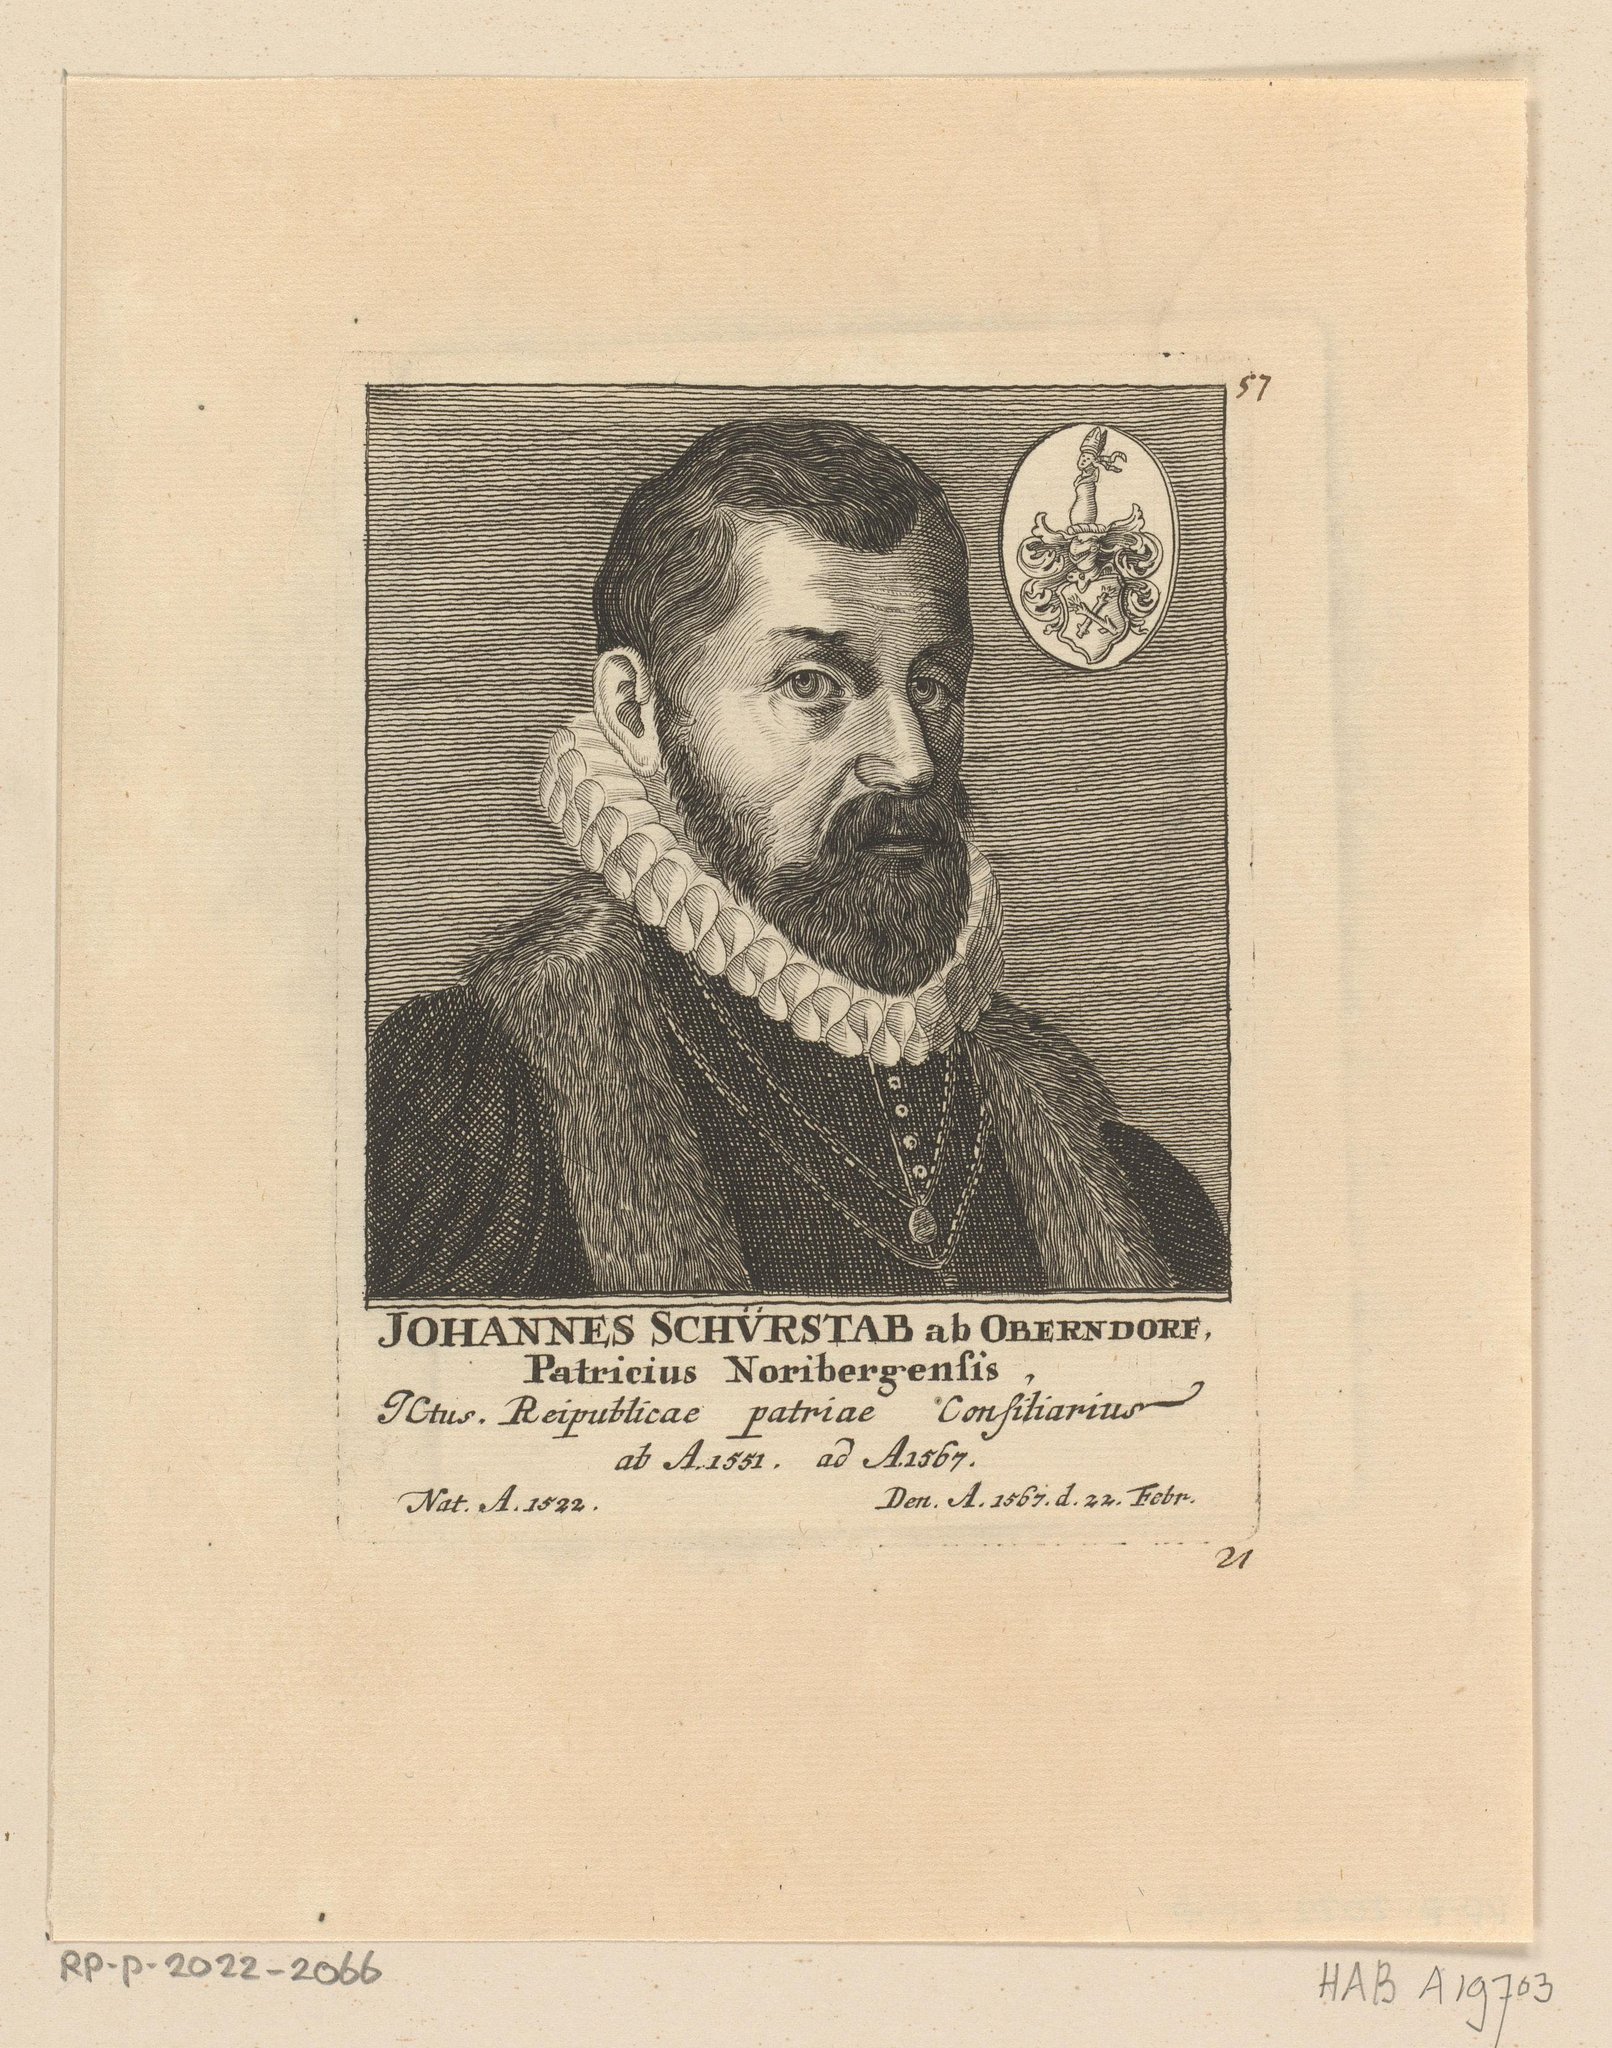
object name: print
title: Icones consiliariorum de illustri republica Noribergensi (…)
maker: Anonymous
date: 1723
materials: paper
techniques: engraving, etching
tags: historical persons, lawyer, attorney at law, armorial bearing, heraldry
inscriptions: number: ‘21’, number: ‘57’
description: Prent waarschijnlijk uit: Rothscholtz, Friedrich. Icones consiliariorum de illustri republica Noribergensi (...). Neurenberg en Altdorf: erven Johann Daniel Tauber, 1723.